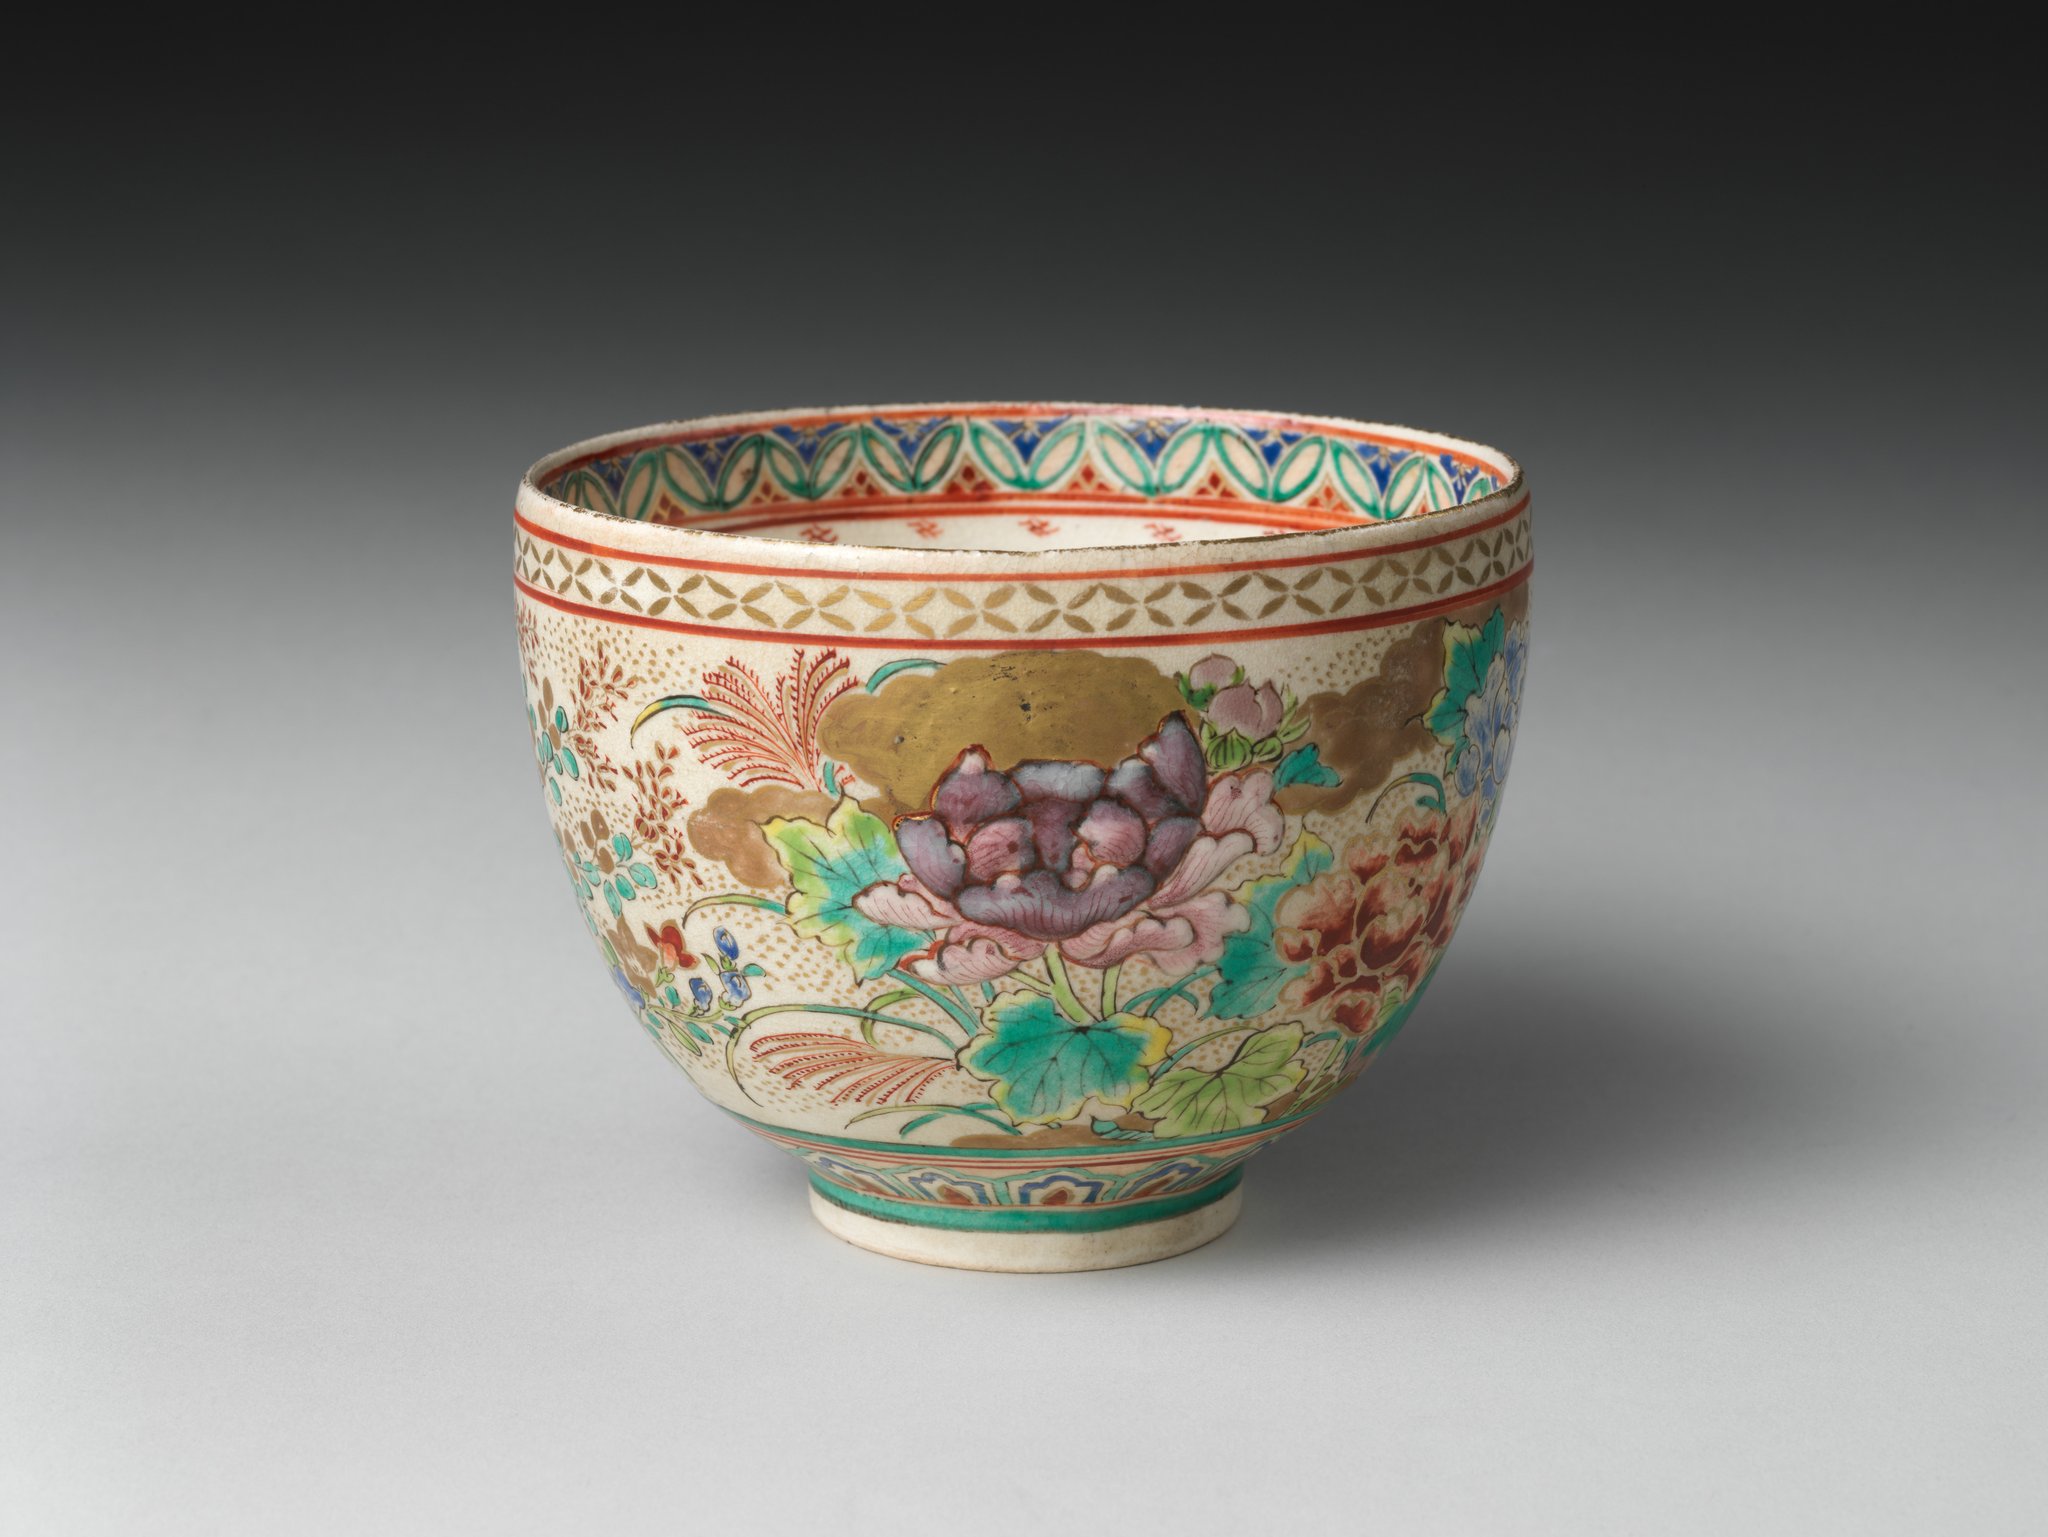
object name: teabowl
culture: japanese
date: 1834-1866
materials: enamel, glaze, gold, stoneware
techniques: polychrome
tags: leaves